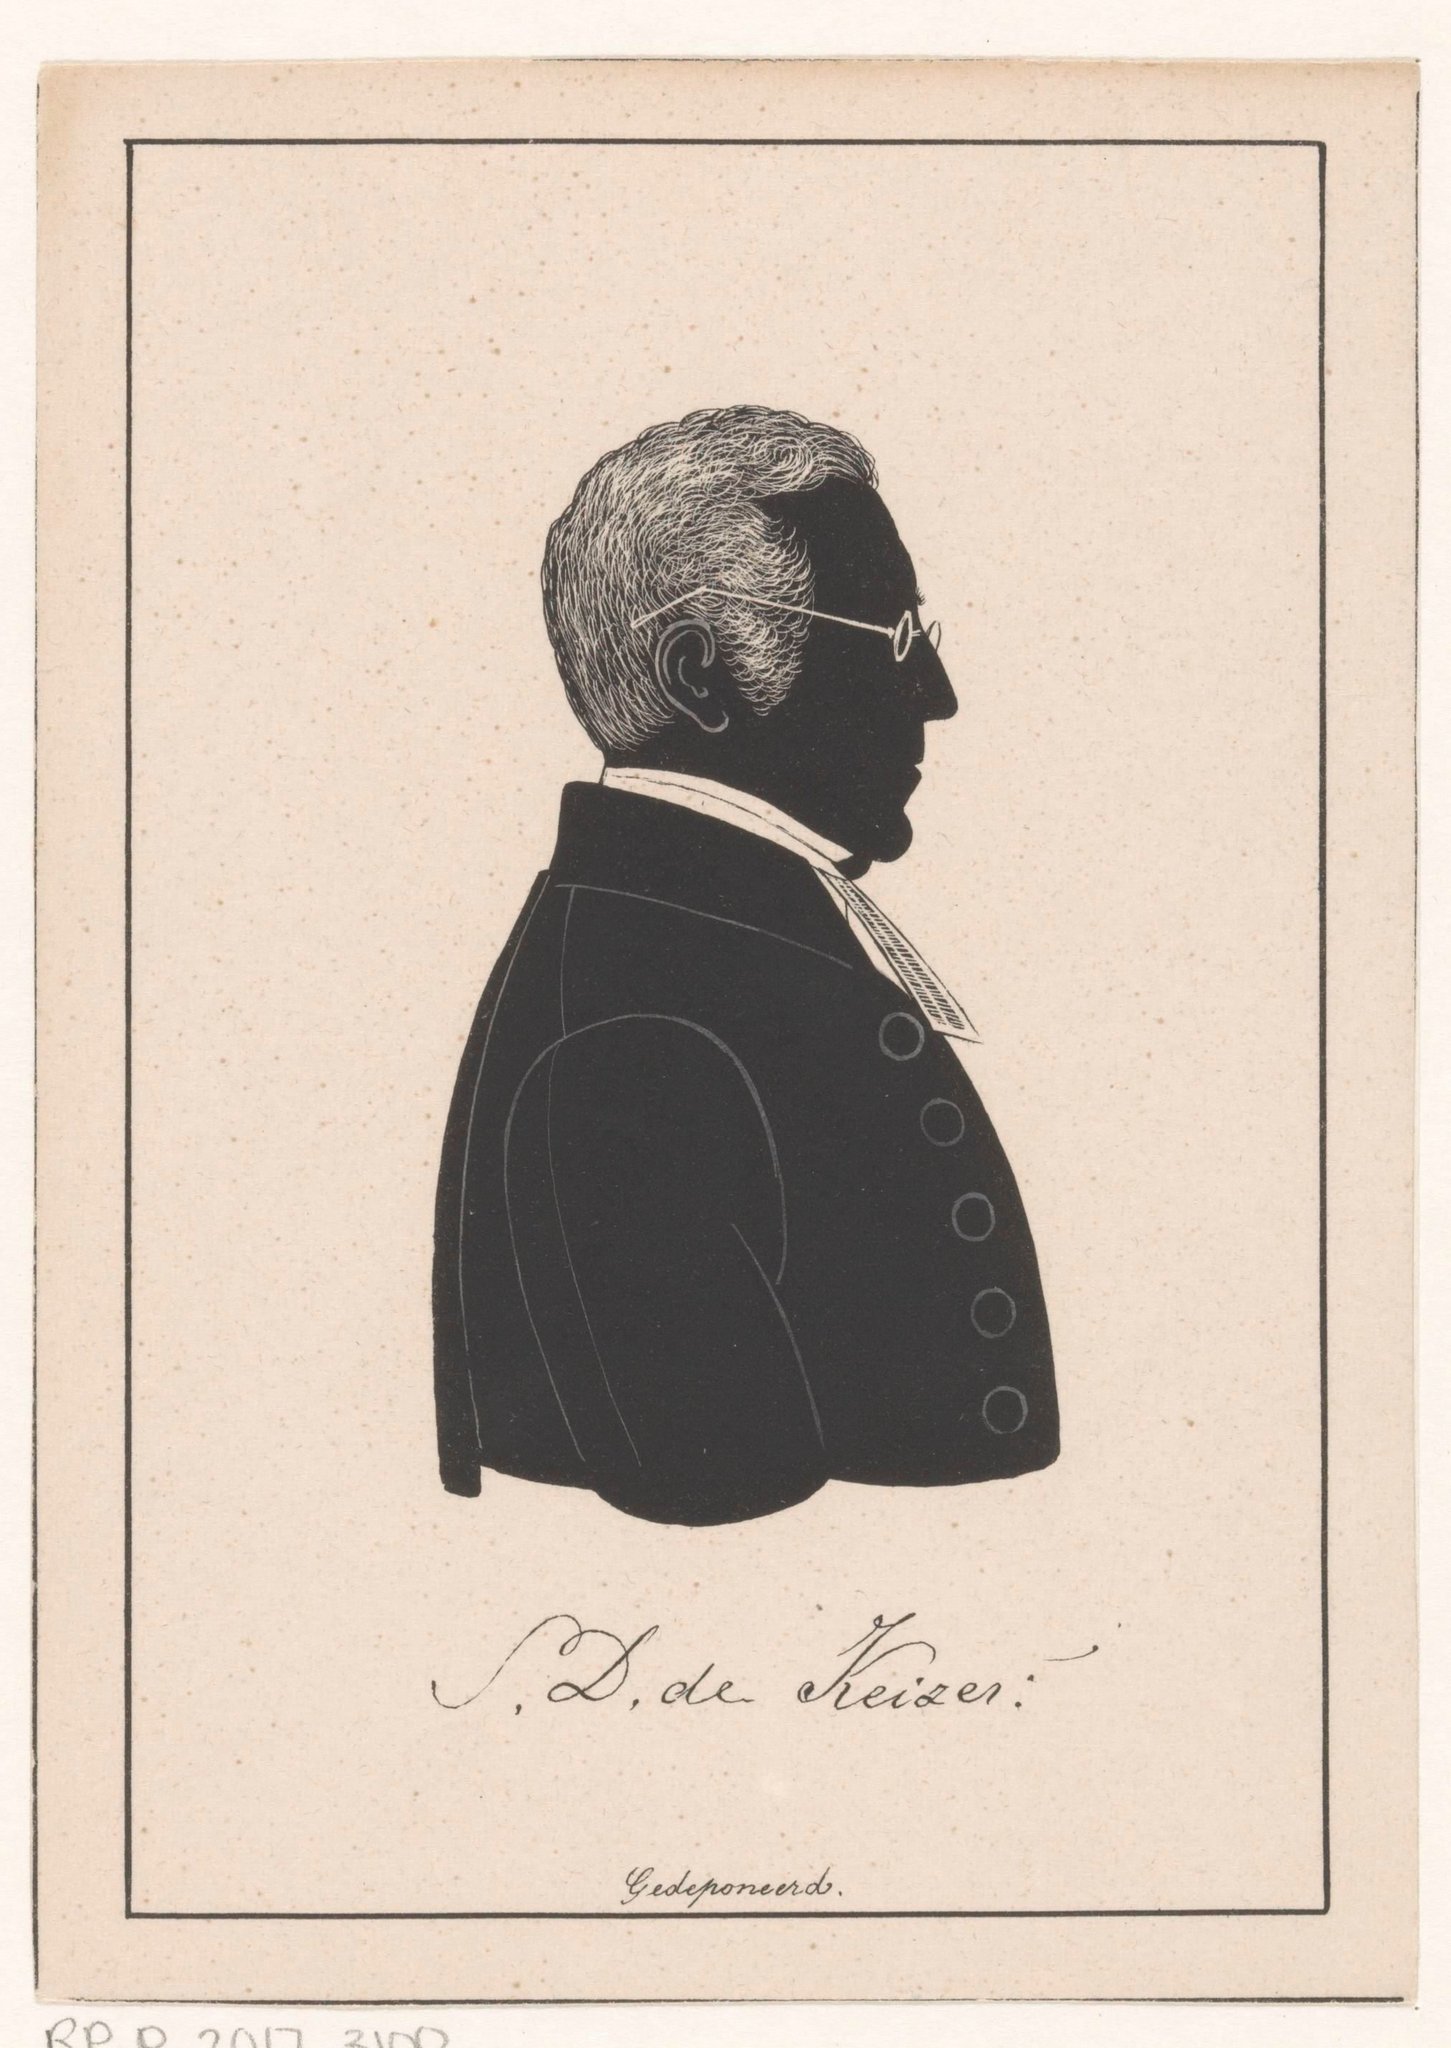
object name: print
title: Silhouetportret van Simon Dirk de Keizer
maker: pieter barbiers (iv)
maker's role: painter, print maker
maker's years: 1798-1848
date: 1809-1848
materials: paper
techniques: hand coloring, lithograph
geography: netherlands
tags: utrecht, historical persons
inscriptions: collector's mark: Lugt 2228, : ‘Gedeponeerd.’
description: Onder het portret de signatuur van de geportretteerde.